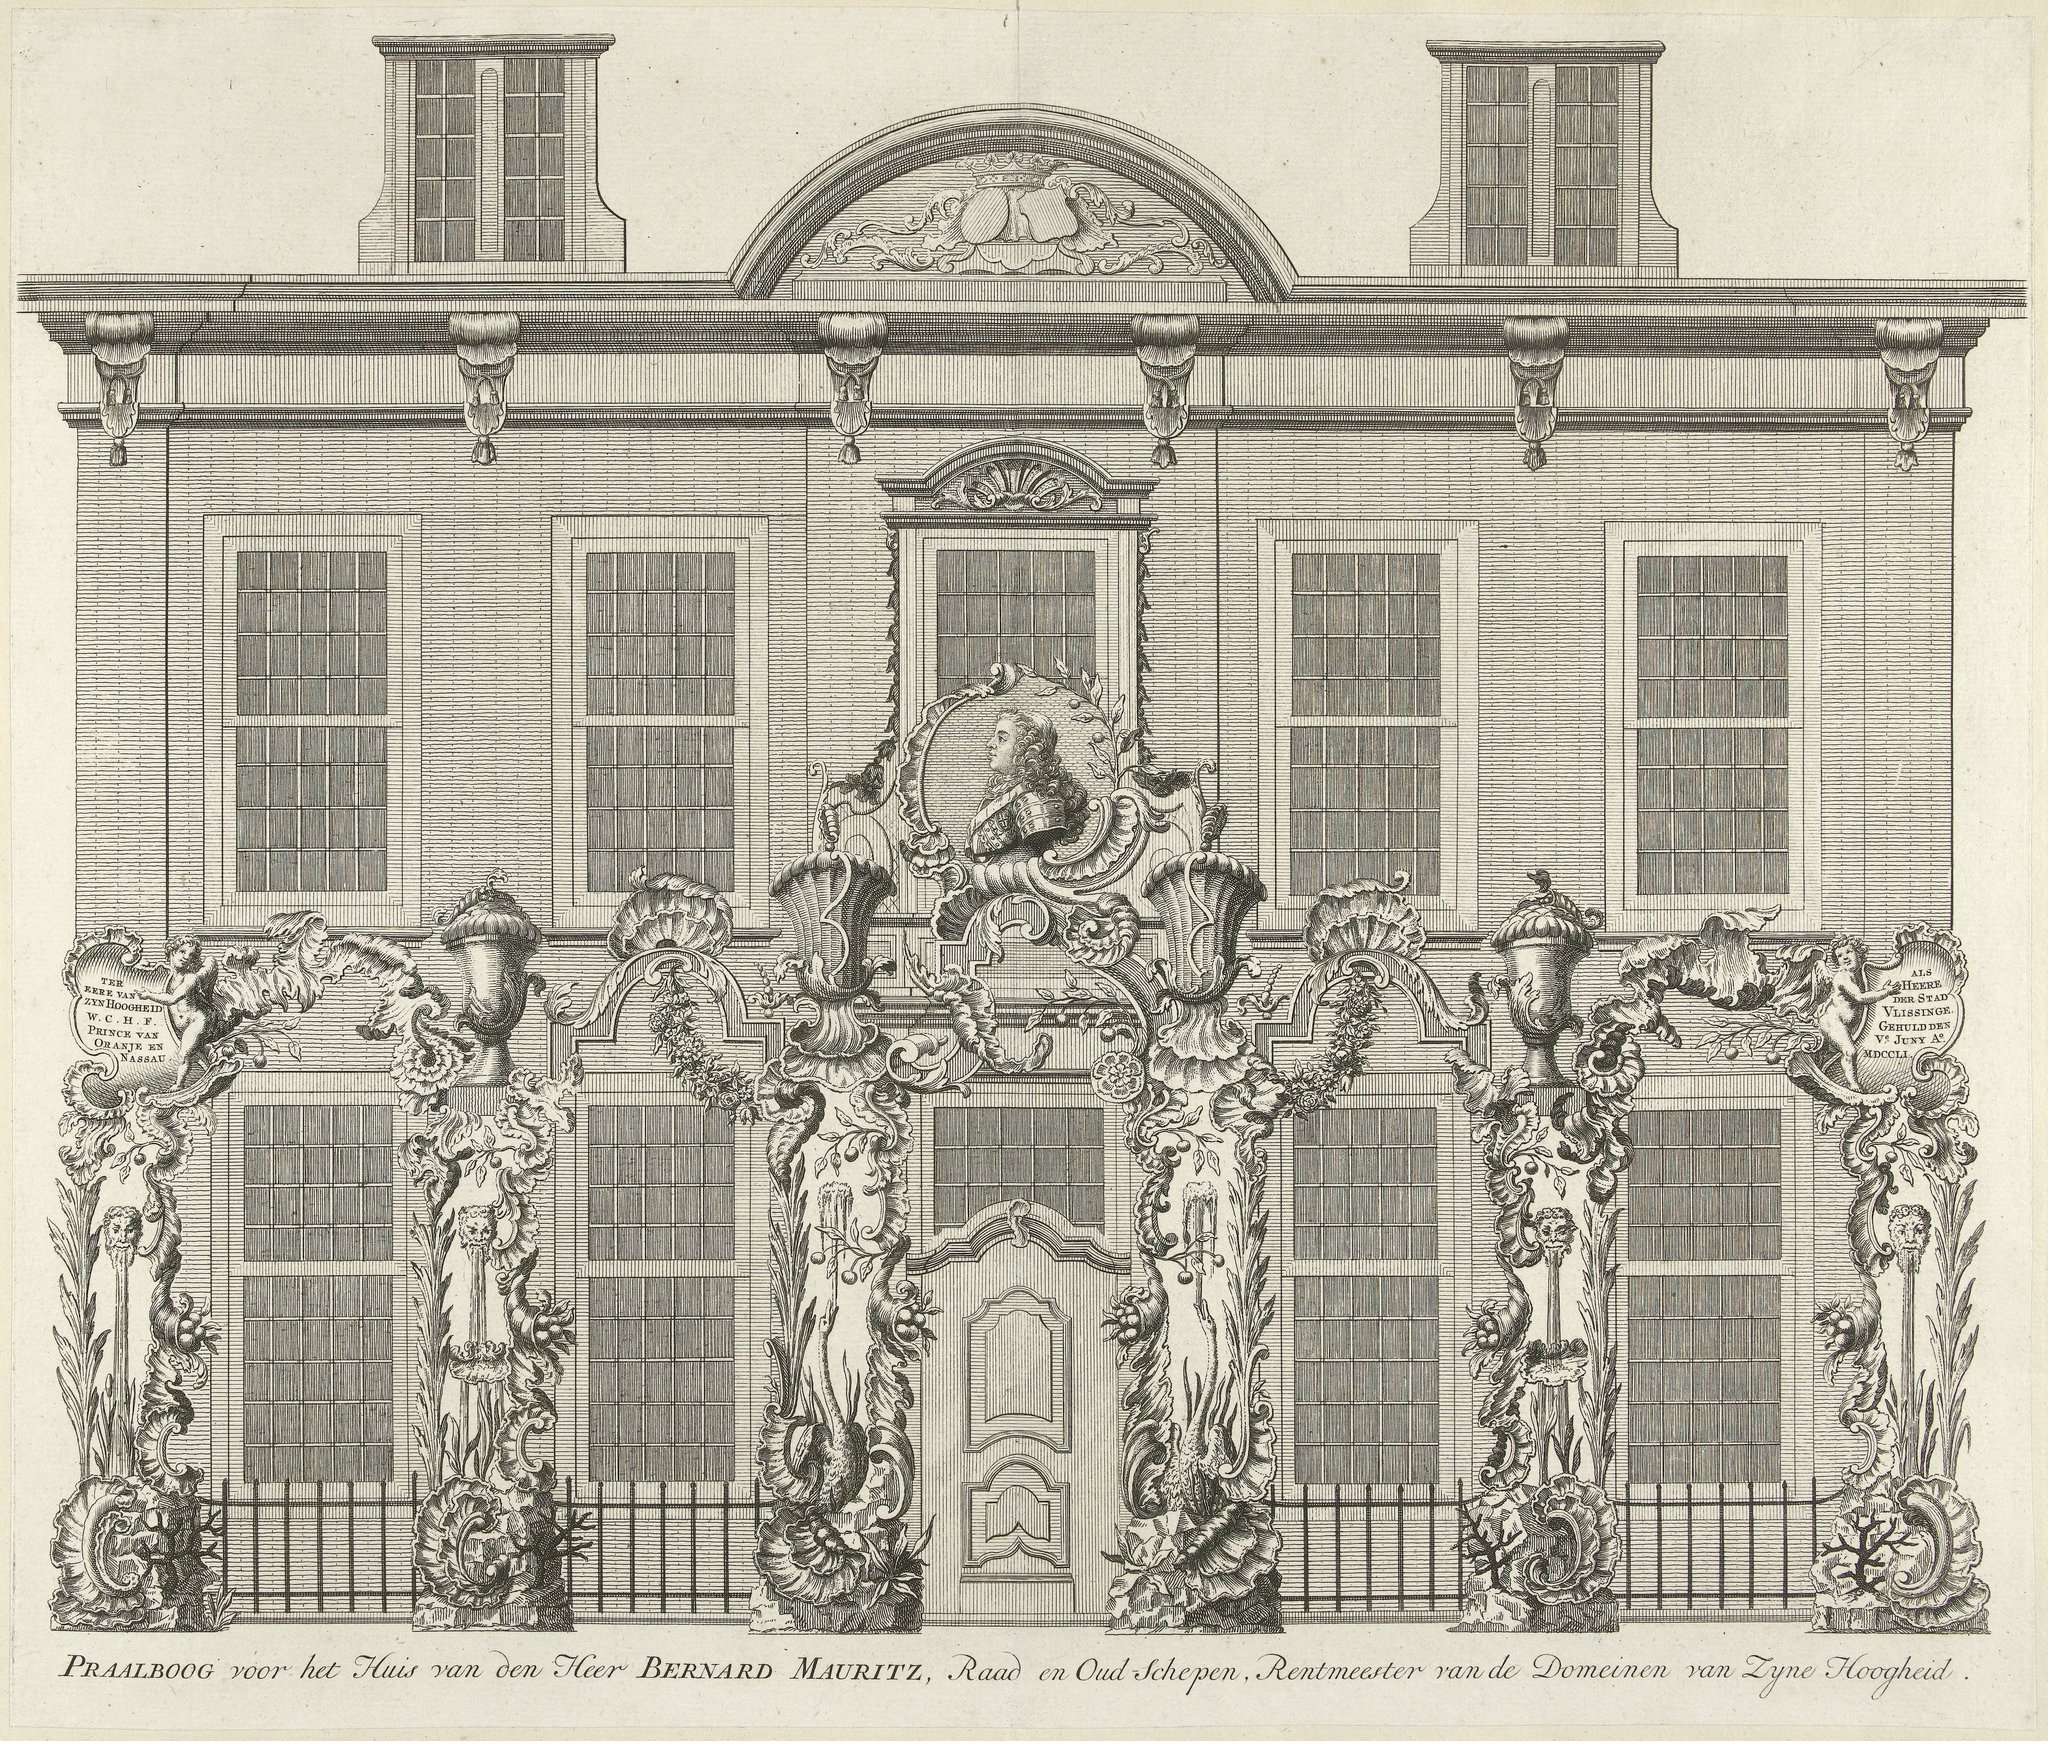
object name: book illustration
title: Praalboog voor het huis van B. Mauritz, 1751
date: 1753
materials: paper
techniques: engraving, etching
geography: middelburg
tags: the hague, willem iv (prins van oranje-nassau), decoration and illumination of streets, squares, etc. (~ triumphal entry, etc.) (+ festive decoration ~ festive activities), flushing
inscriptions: collector's mark: Lugt 2228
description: Praalboog aangebracht voor het huis van Bernard Mauritz, een raad en oudschepen van Vlissingen en rentmeester van de stadhouder. Praalboog ontworpen en beschilderd door Jan Huis, schilder te Middelburg. Onderdeel van de illustraties van de inhuldiging van Willem IV als erfheer van Vlissingen op 5 juni 1751.